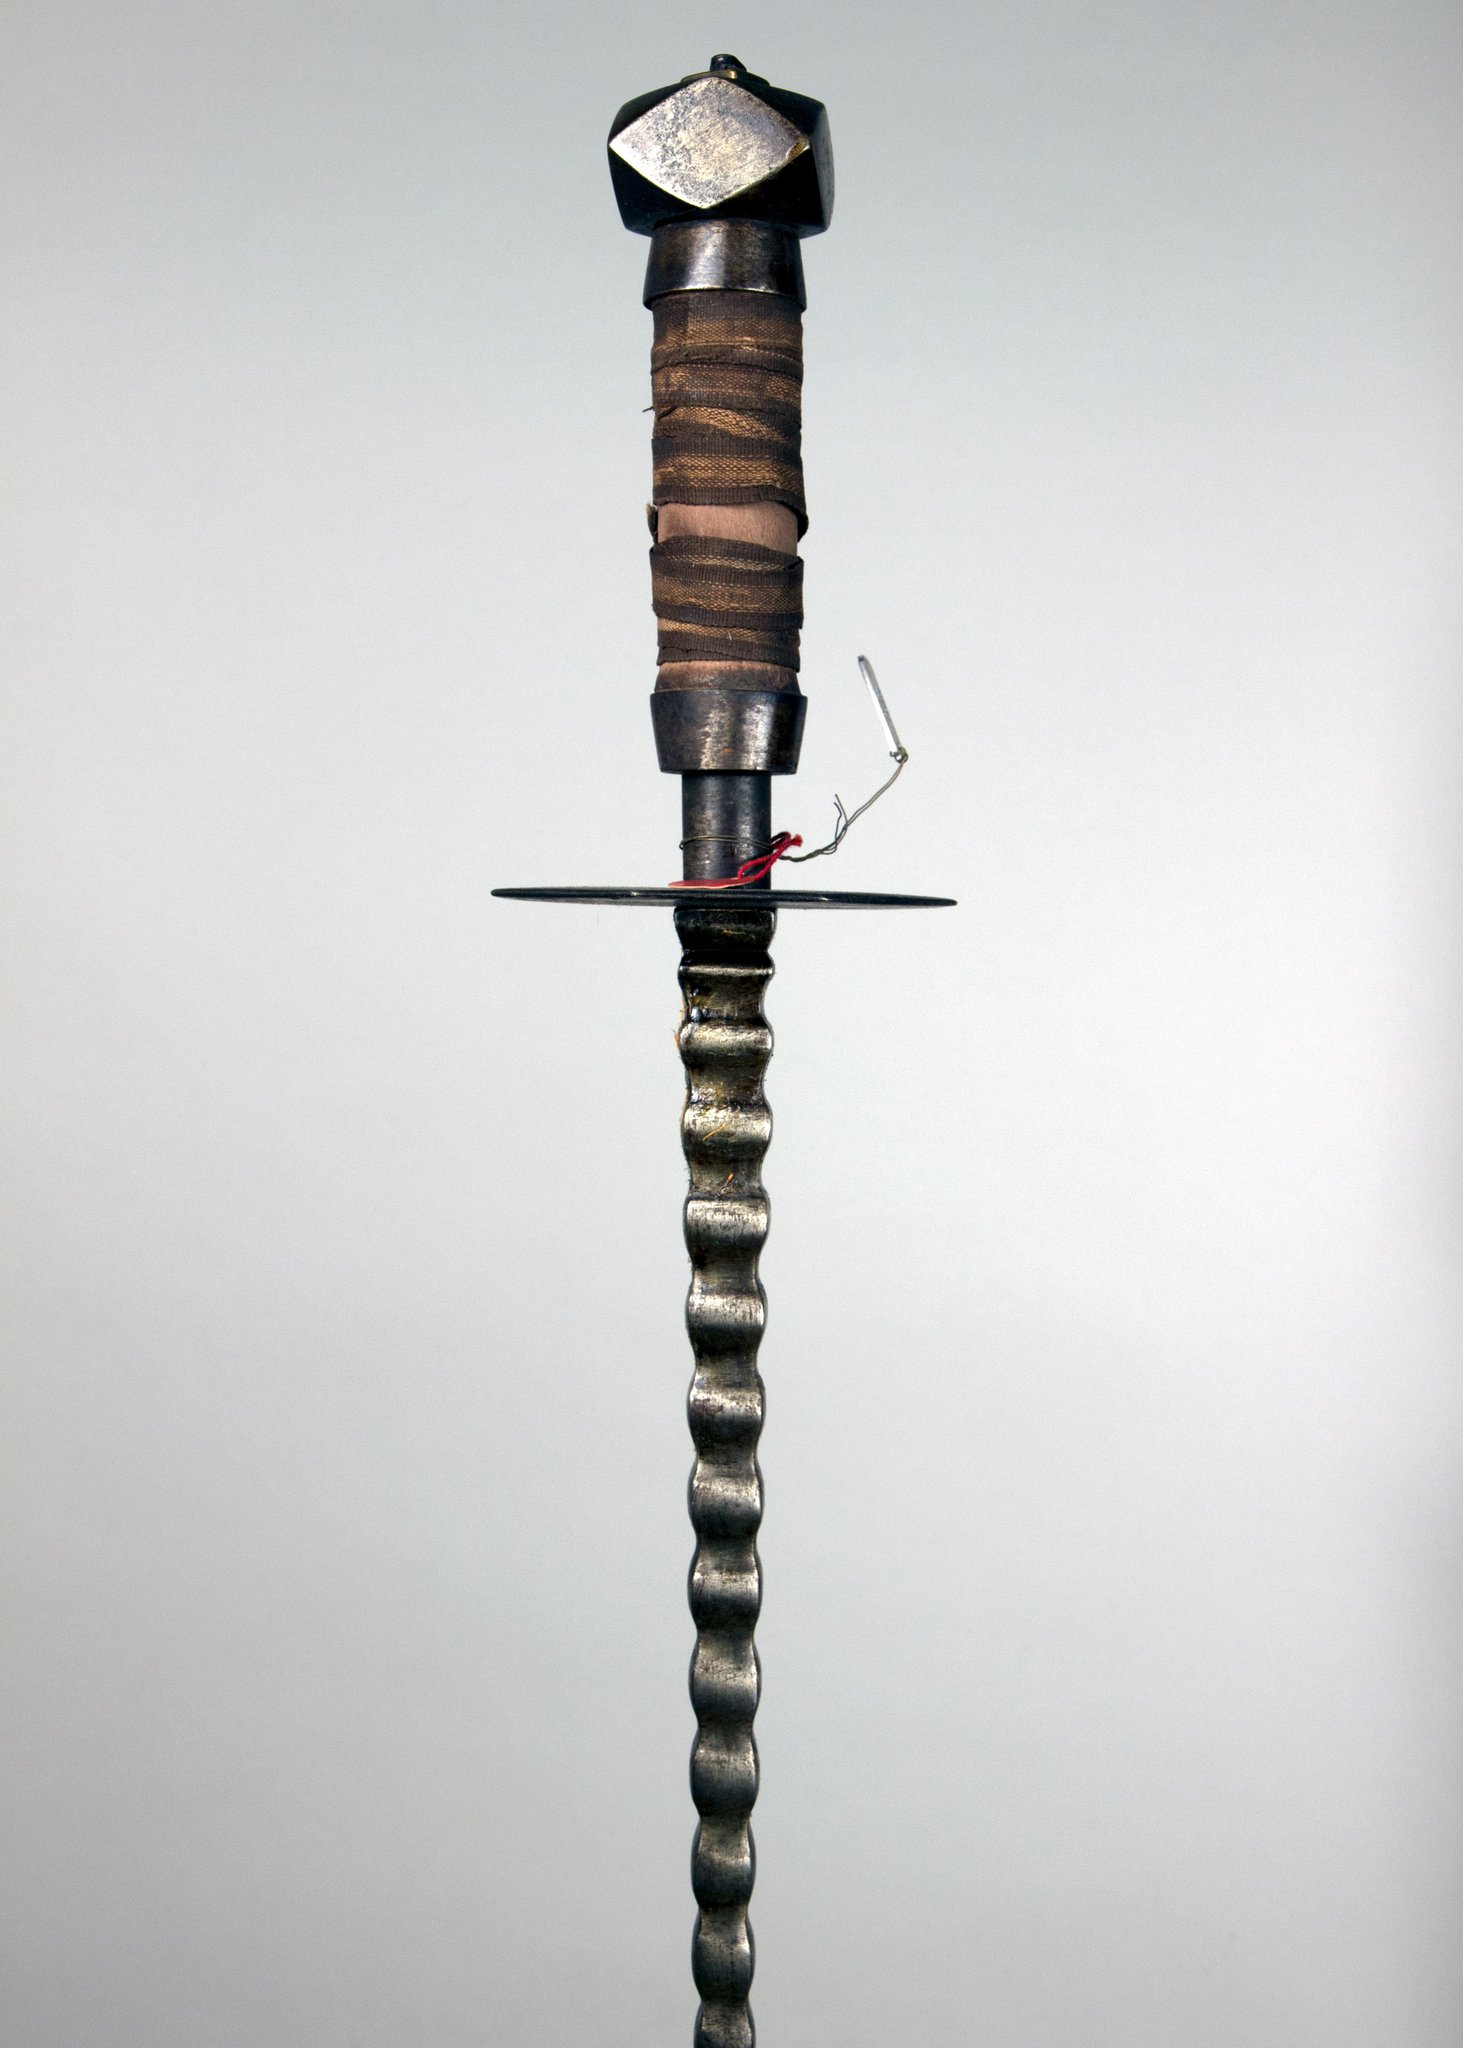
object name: mace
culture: chinese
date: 1701-1900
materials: steel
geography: china